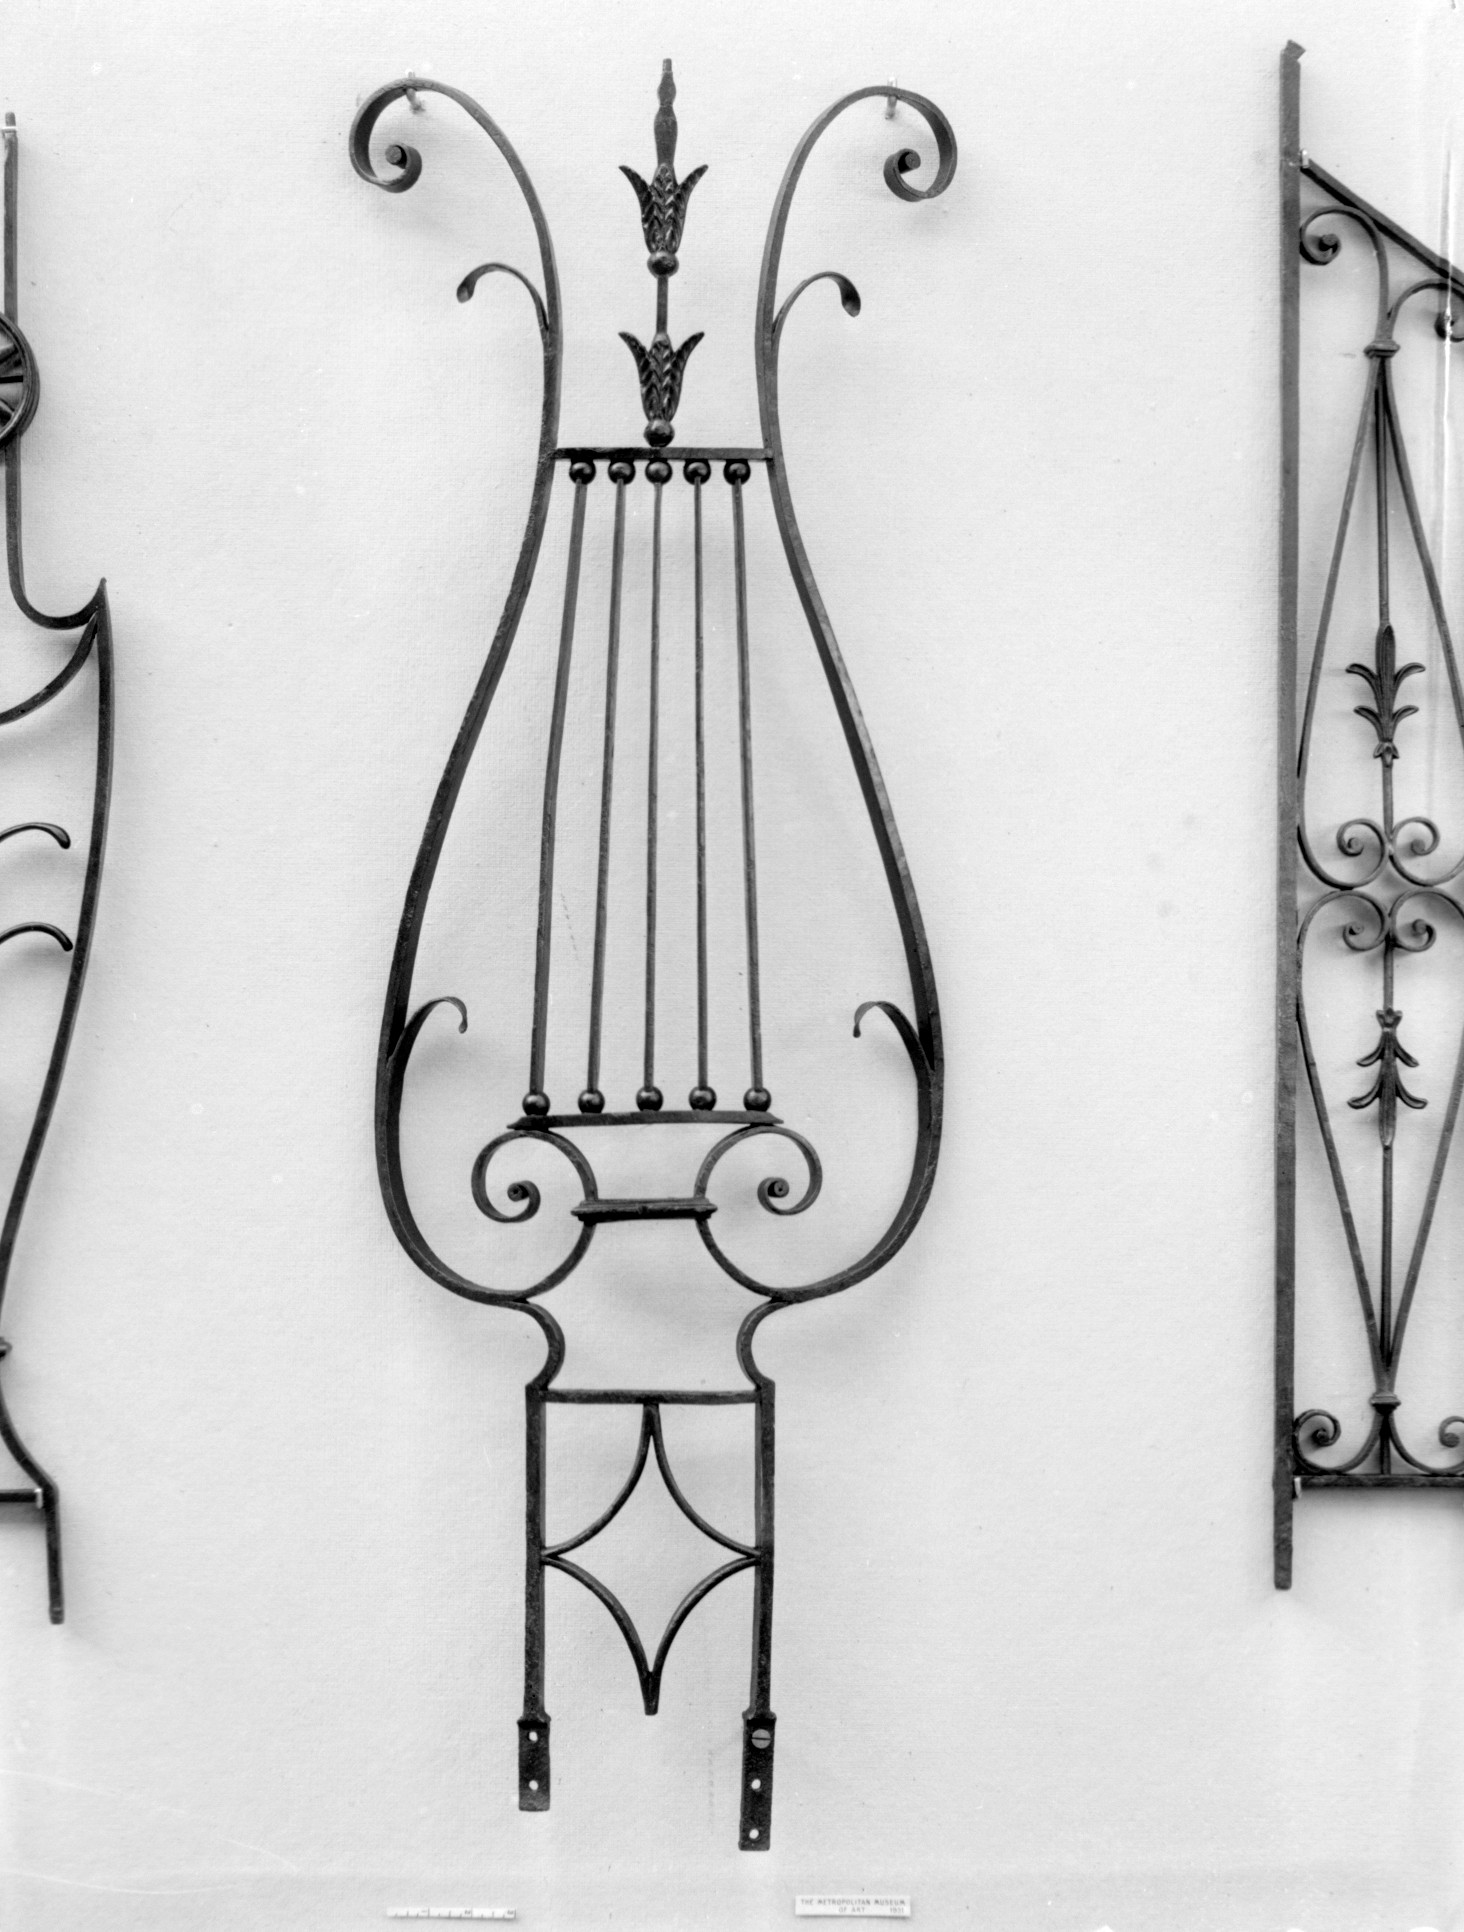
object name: baluster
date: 1780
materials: lead, iron